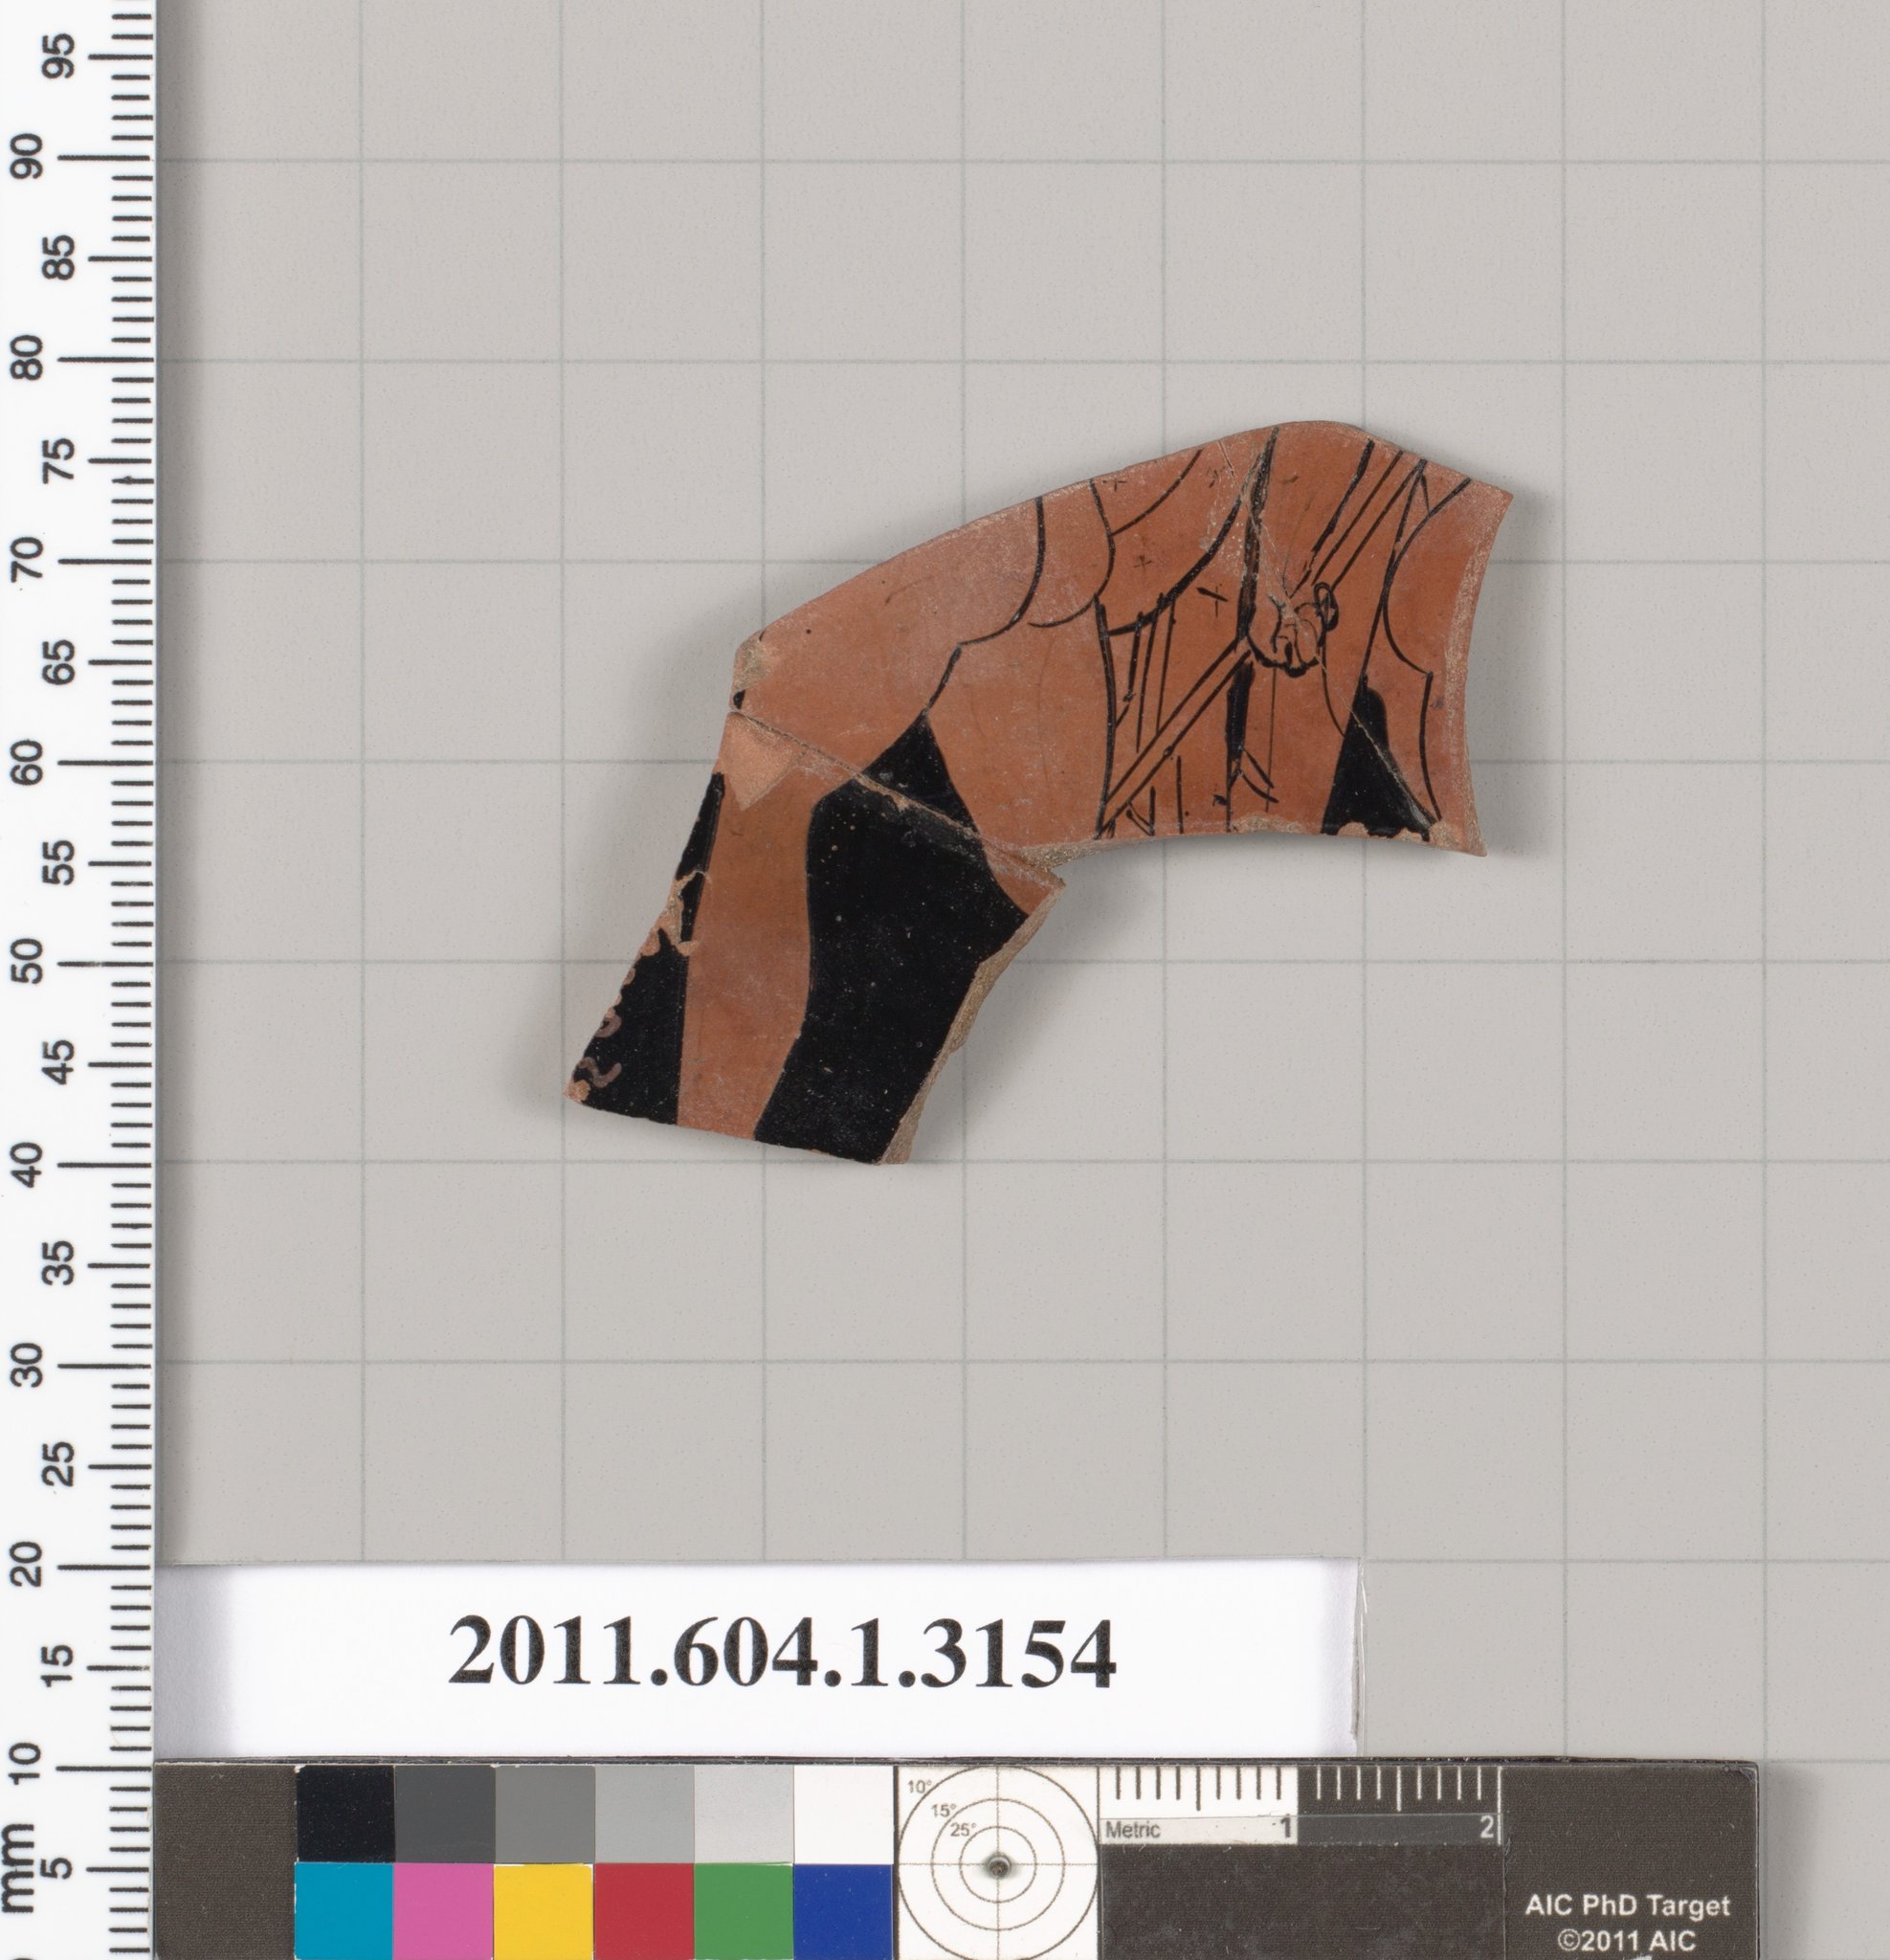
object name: kylix fragment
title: Terracotta fragment of a kylix (drinking cup)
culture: greek, attic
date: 500-476 BCE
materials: terracotta